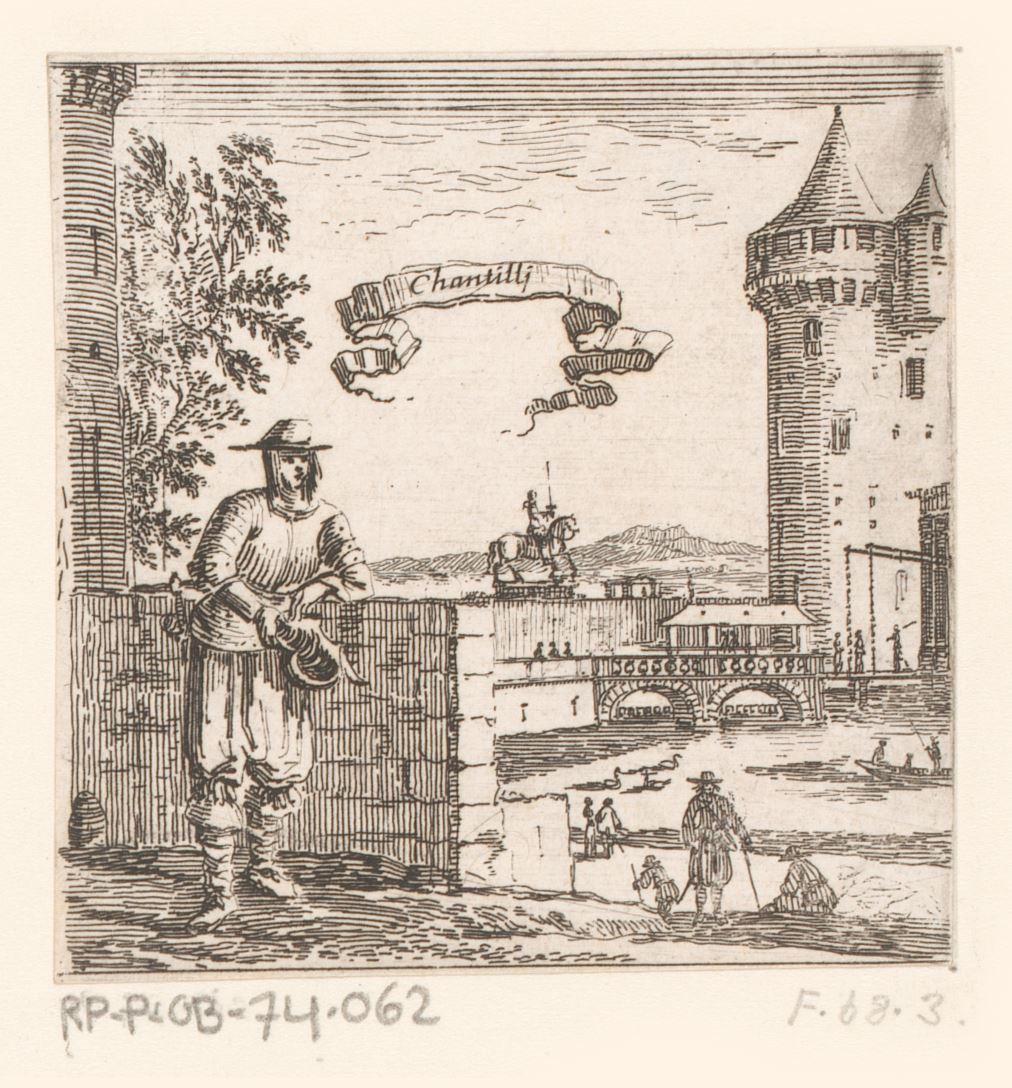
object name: print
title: Gezicht op het kasteel van Chantilly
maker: israël silvestre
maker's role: draughtsman, print maker, publisher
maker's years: 1621-1691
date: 1656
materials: paper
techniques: etching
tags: landscape with tower or castle, chantilly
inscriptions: collector's mark: Lugt 240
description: Prent maakt deel uit van een ongenummerde serie van acht prenten.